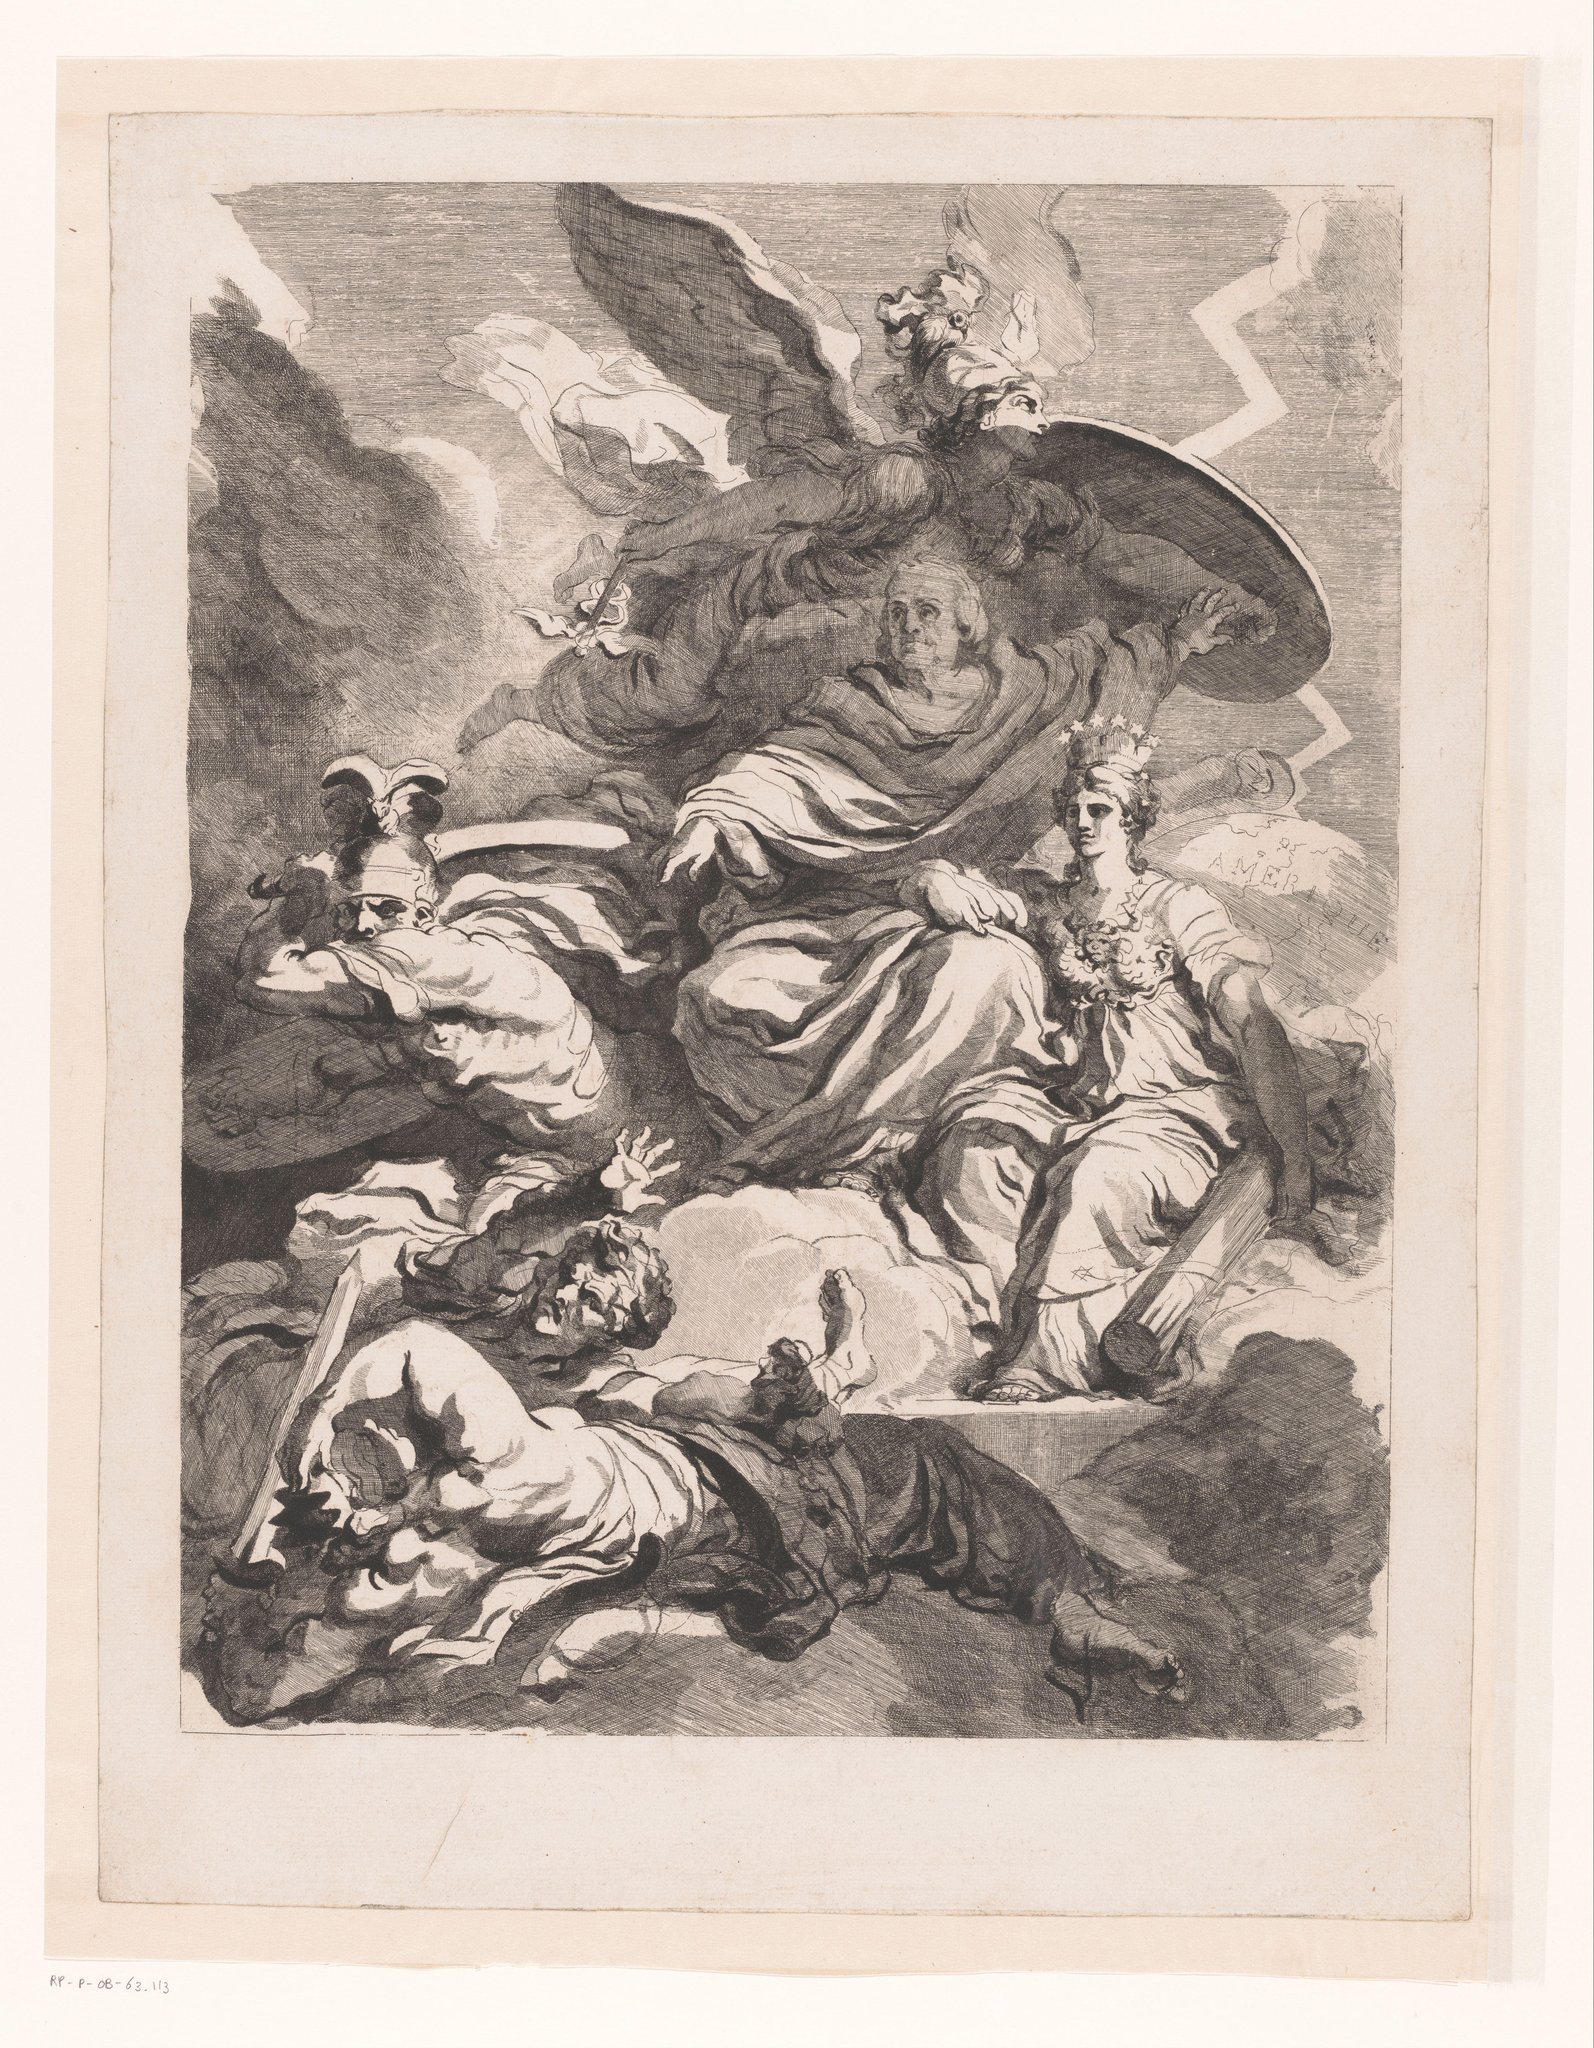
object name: print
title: Allegorische voorstelling van Amerika met Benjamin Franklin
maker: jean honoré fragonard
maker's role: draughtsman, painter, print maker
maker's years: 1732-1806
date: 1778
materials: paper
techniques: etching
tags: physicist, america represented allegorically; 'america' (ripa), historical persons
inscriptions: inscription: ‘43-1/2’, inscription: ‘Eripuit coelo fulmen sceptrumque tirannis/ Au genie de Franklin’